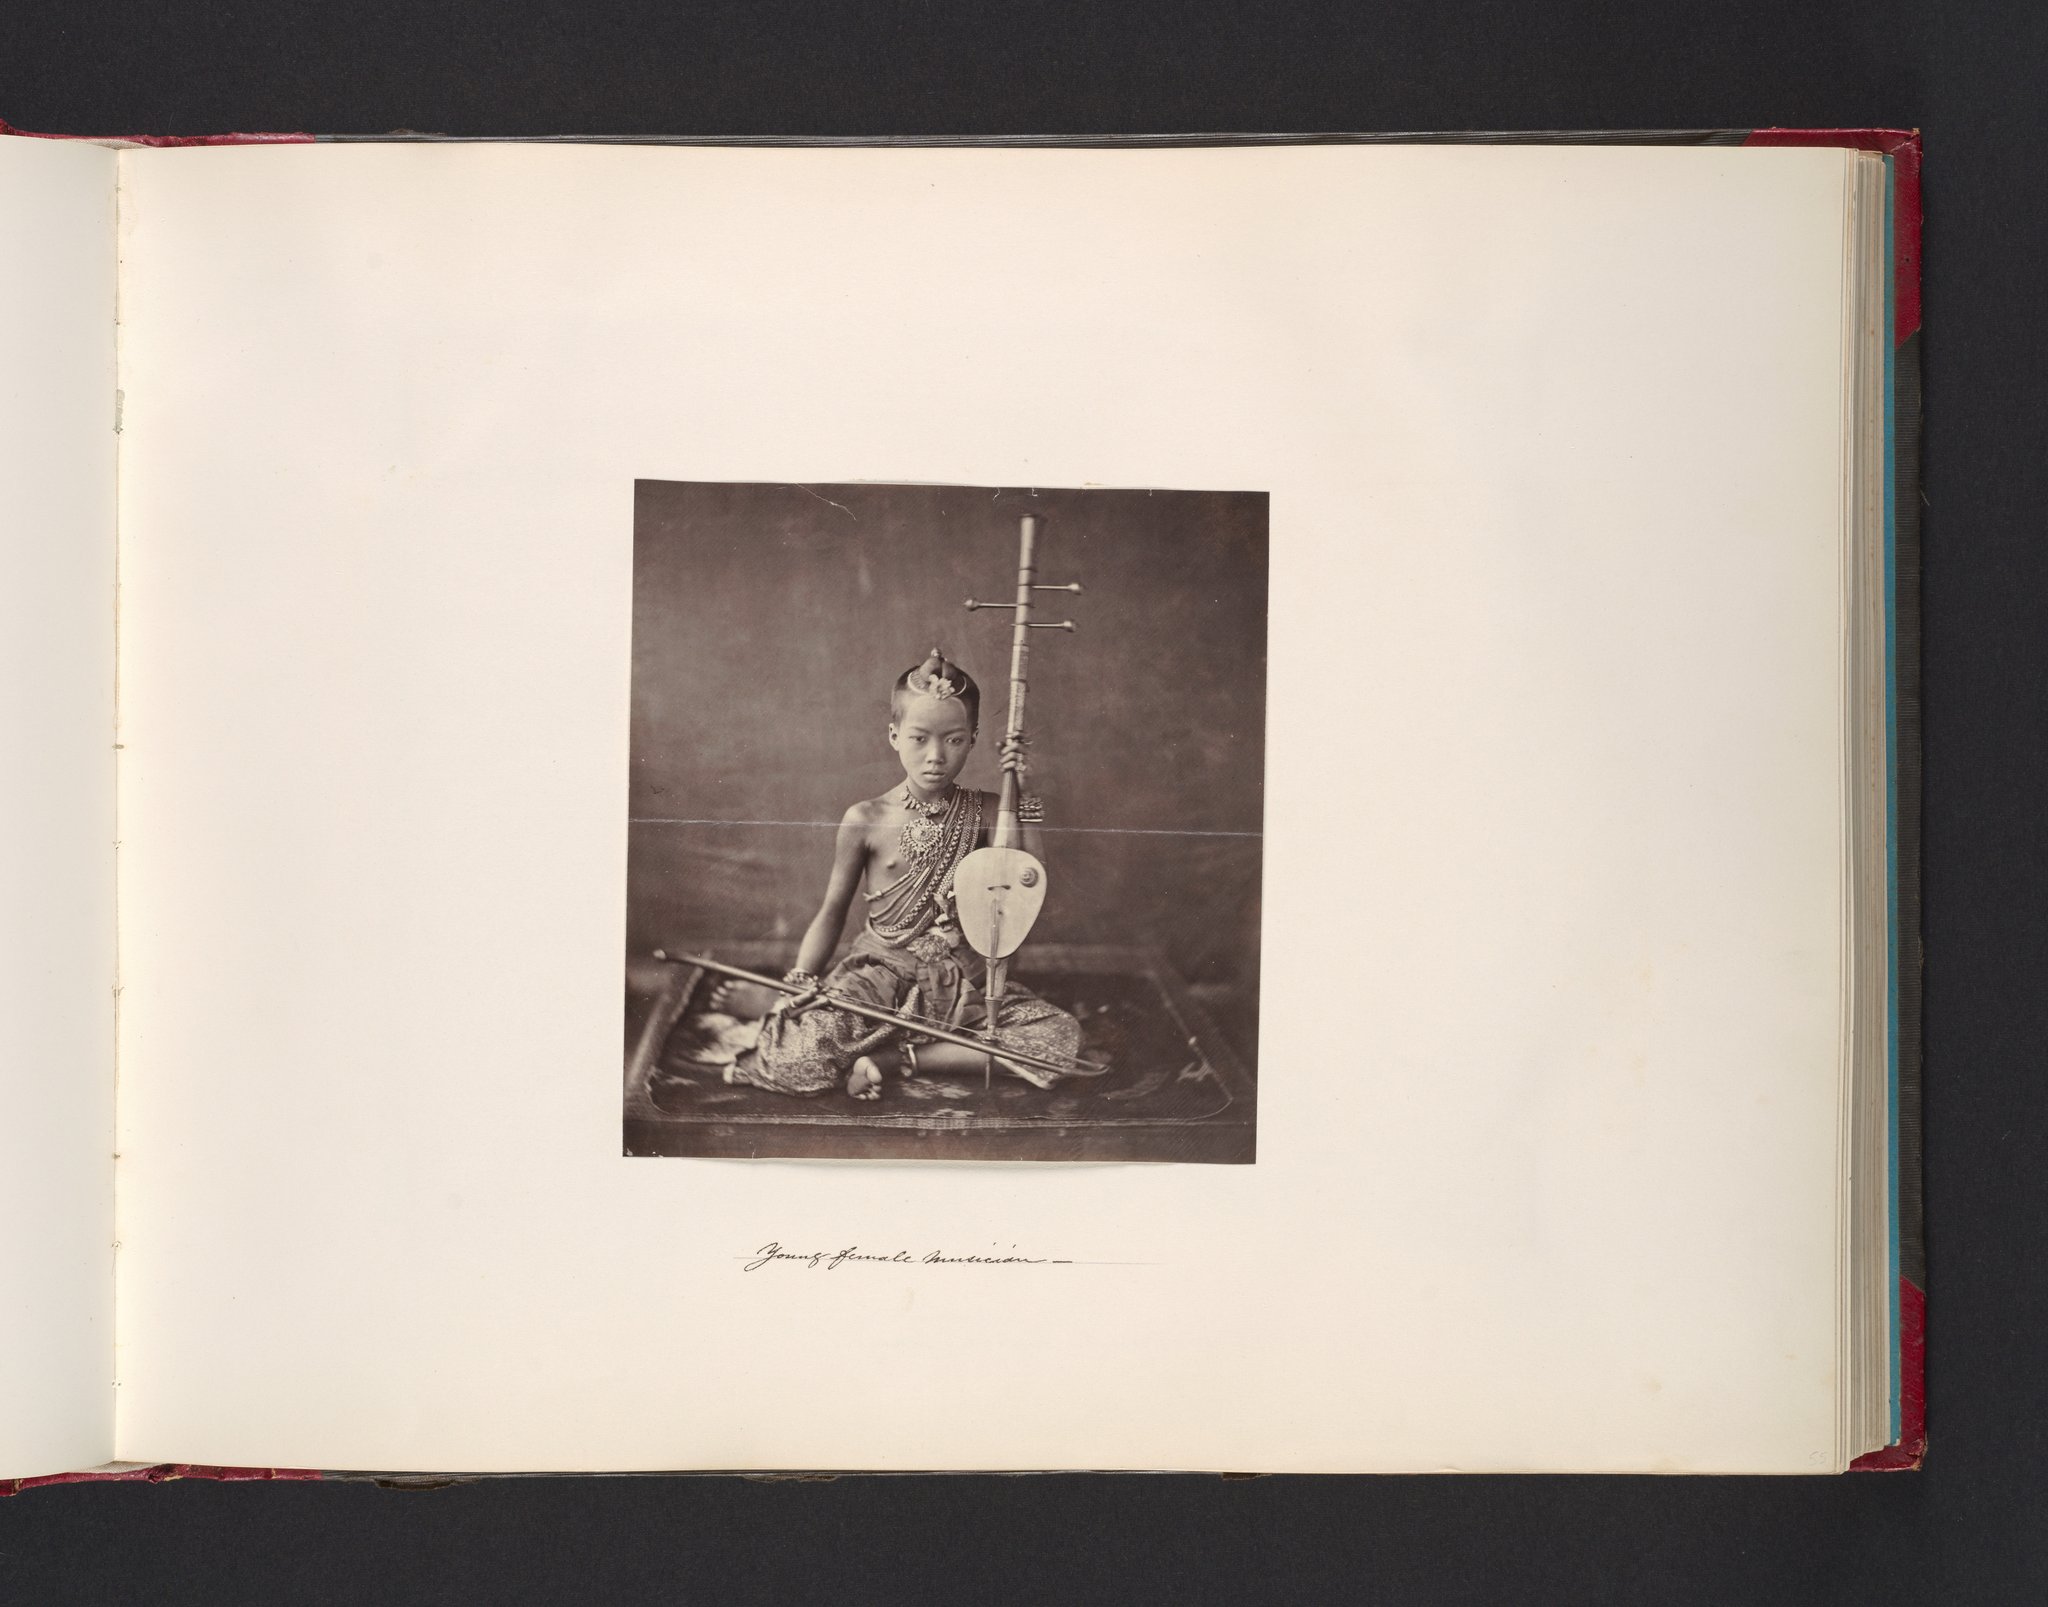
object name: photograph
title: Young Female Musician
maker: john thomson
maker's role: artist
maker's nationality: british, scottish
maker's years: 1837-1921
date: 1865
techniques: albumen silver print, glass negative